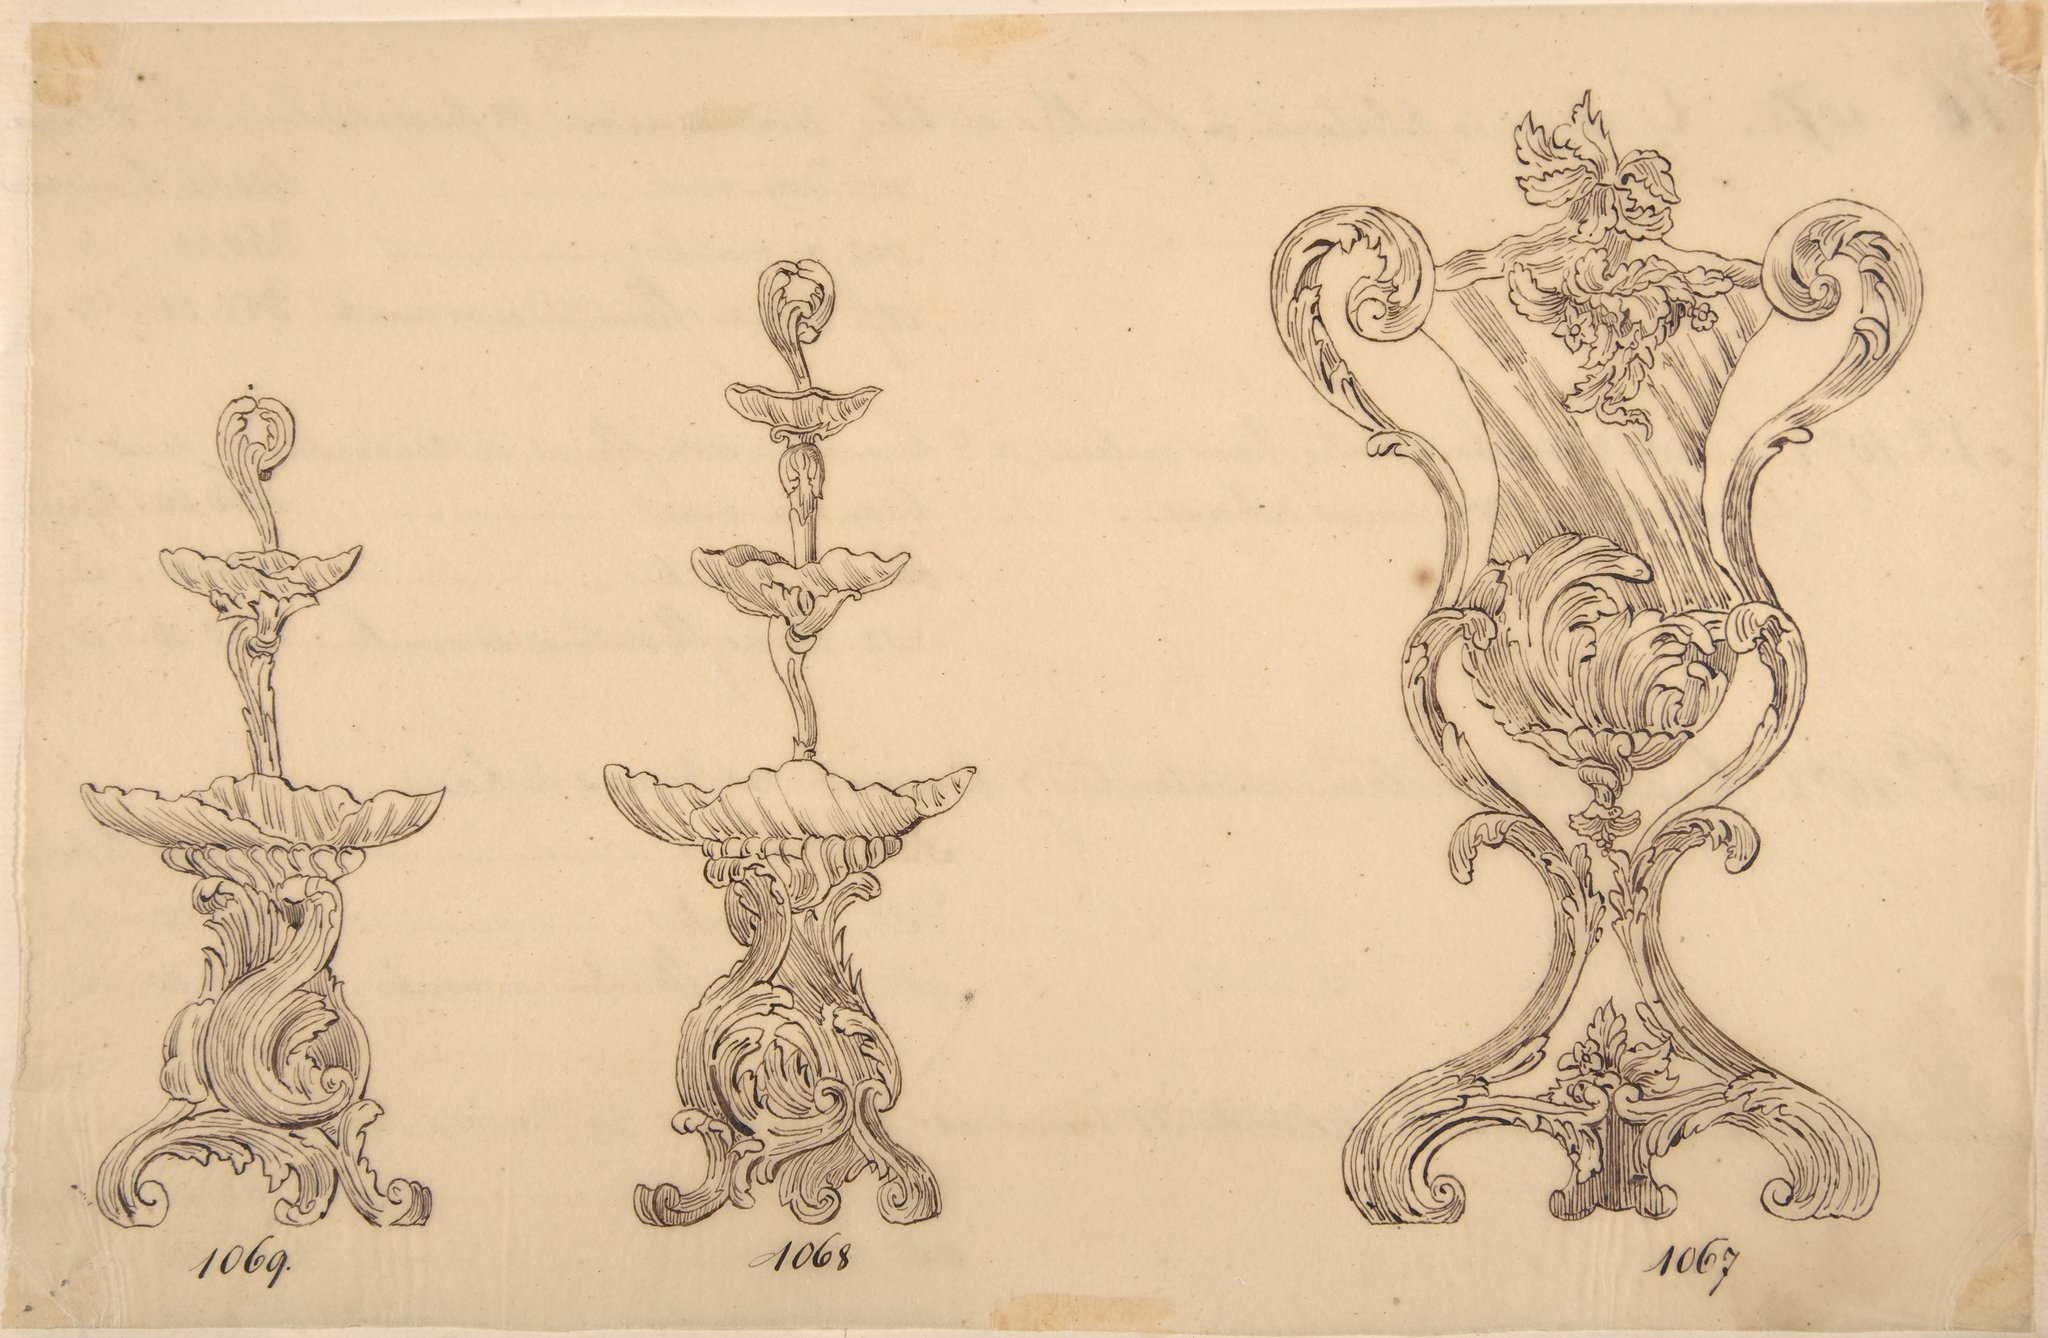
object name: drawing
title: Designs for Two Servers and an Urn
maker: anonymous, french, 19th century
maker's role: artist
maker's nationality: french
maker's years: 1800-1900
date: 1801-1900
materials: ink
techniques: pen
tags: urns